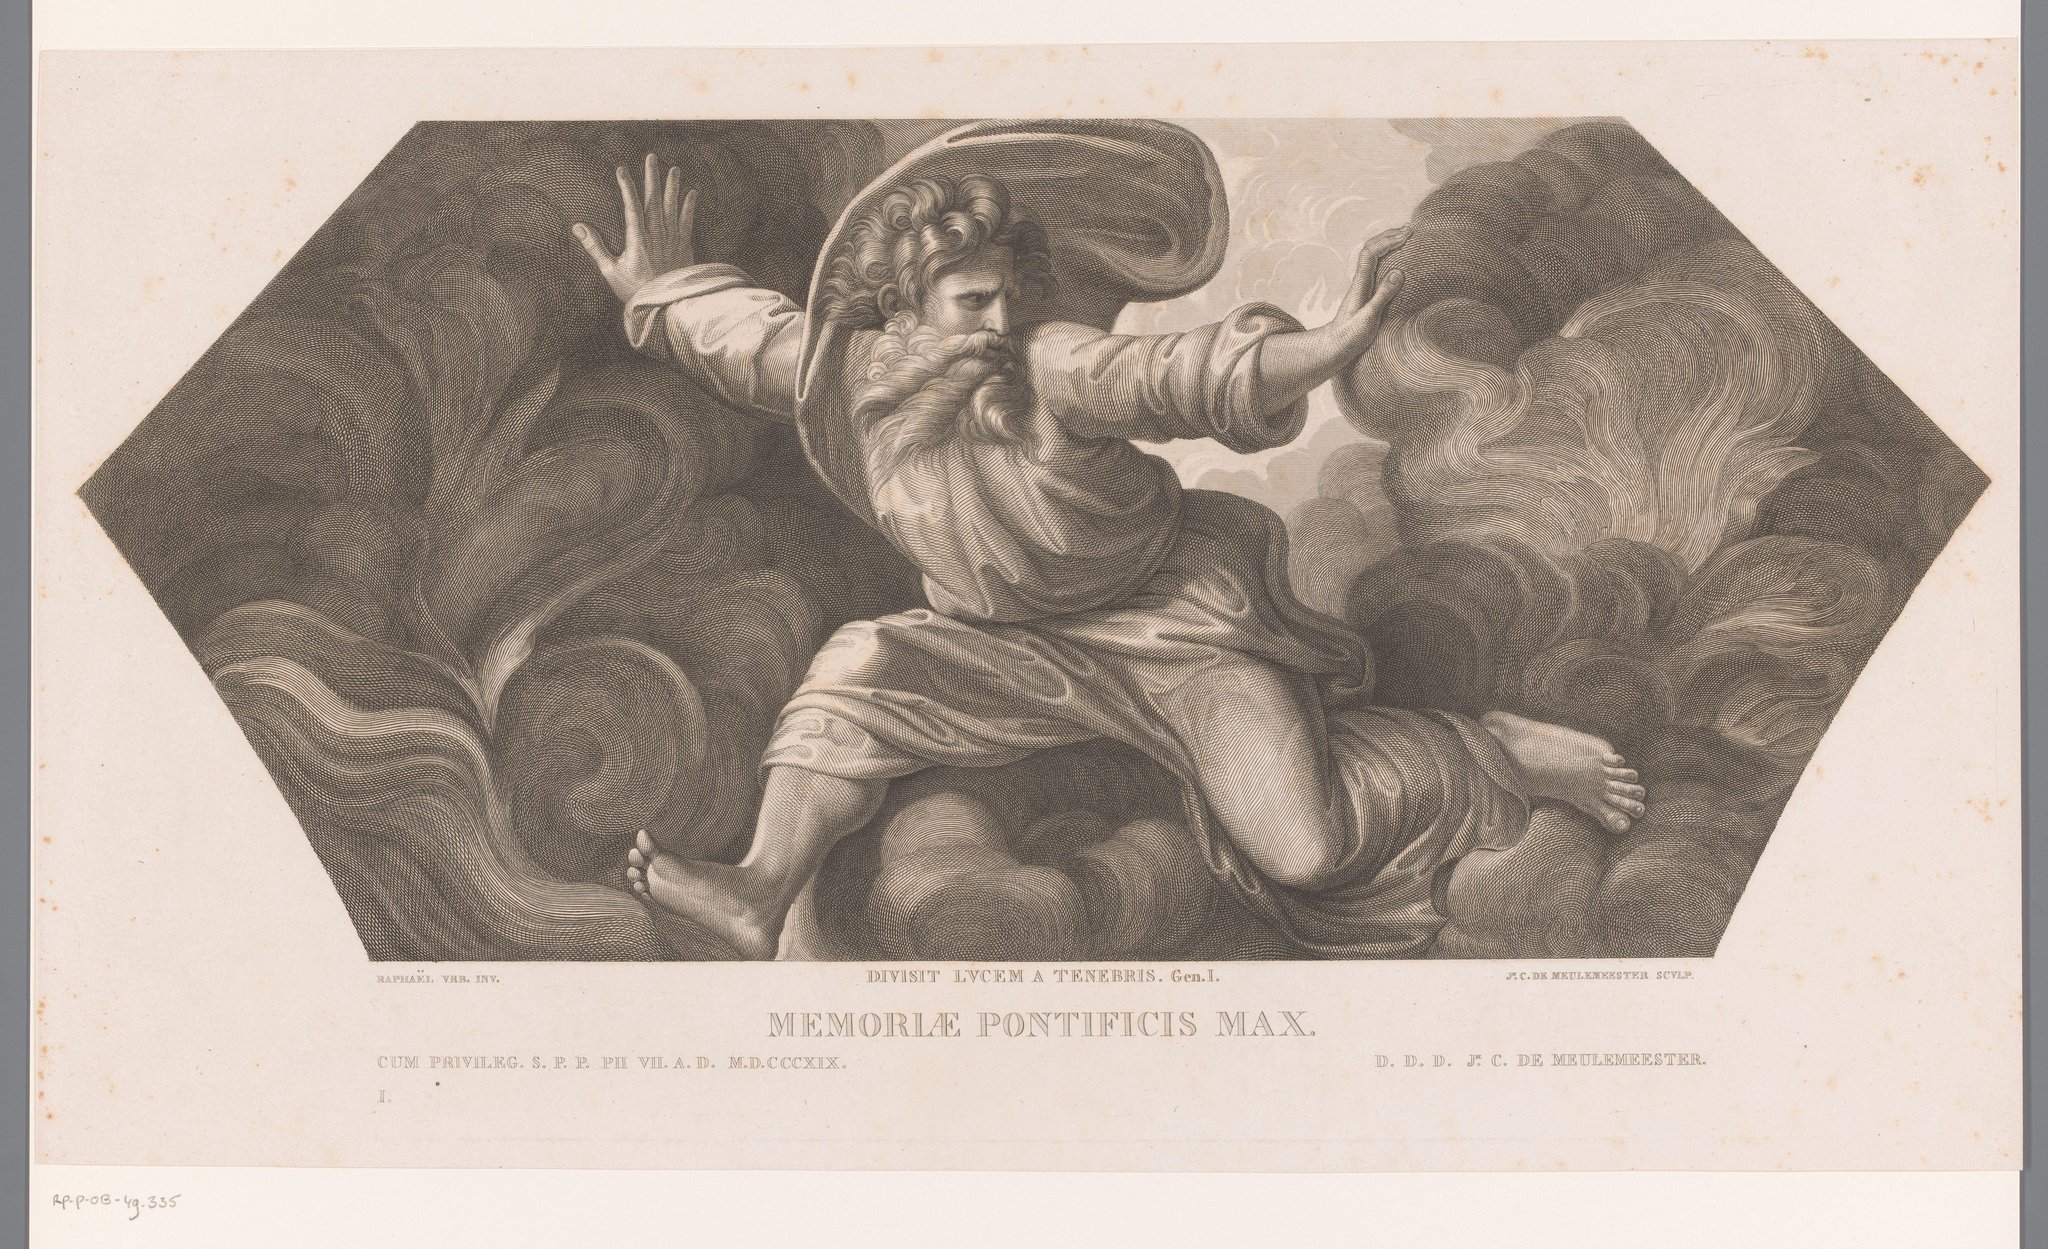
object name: print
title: God scheidt het licht van de duisternis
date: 1819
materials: paper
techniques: engraving, etching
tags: division of light and darkness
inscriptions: mark: ‘M’, collector's mark: Lugt 12